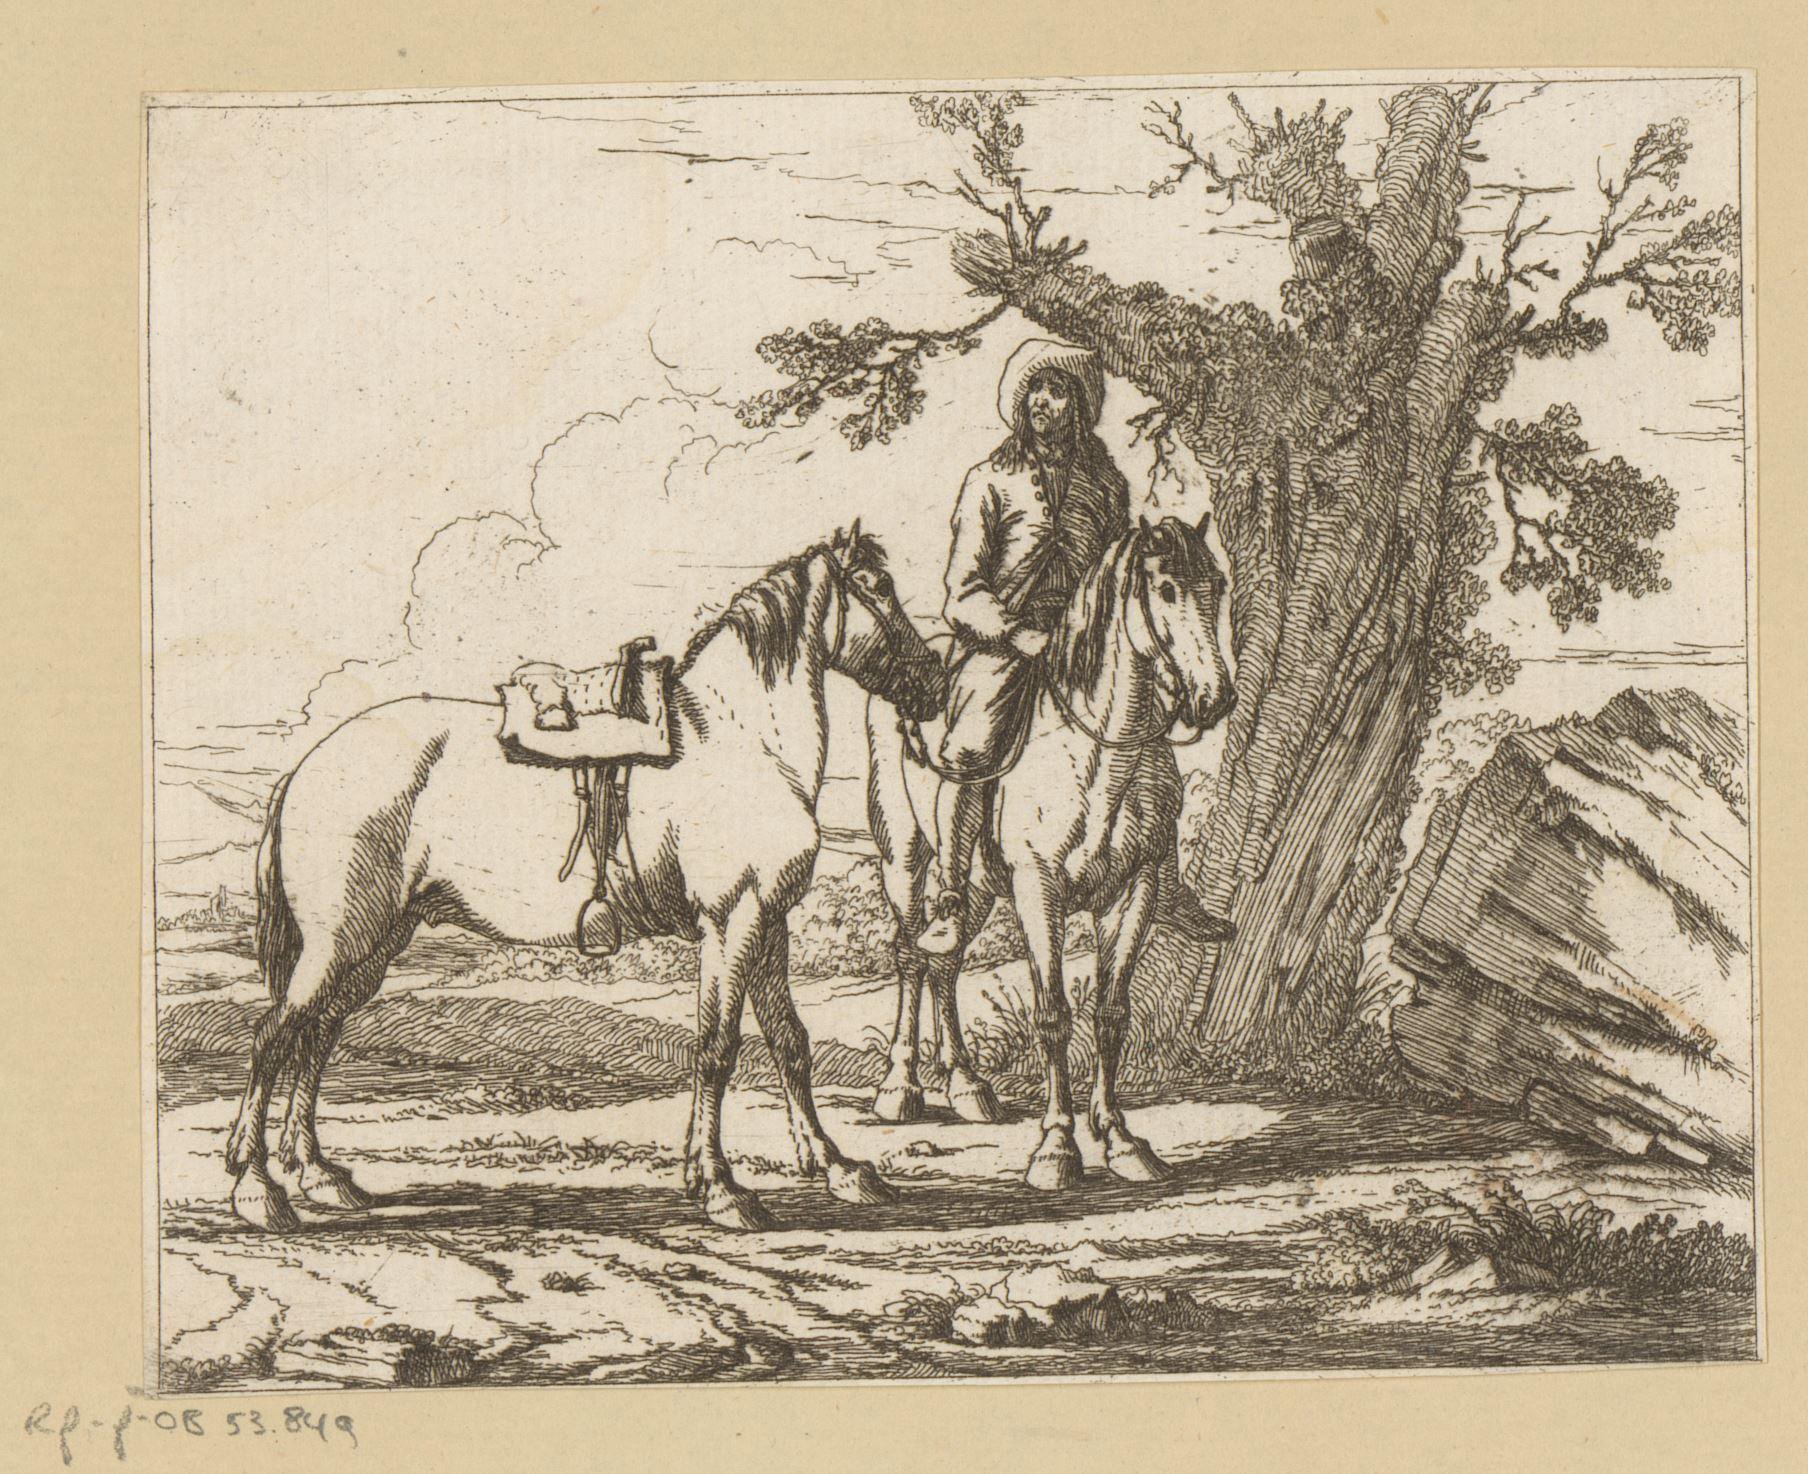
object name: print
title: Ruiters met ruïnes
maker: georg philipp rugendas (i)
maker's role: draughtsman, print maker, publisher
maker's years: 1666-1742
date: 1676-1742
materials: paper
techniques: etching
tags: riding a horse, ass, or mule; rider, horseman, landscapes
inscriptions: collector's mark: Lugt 240